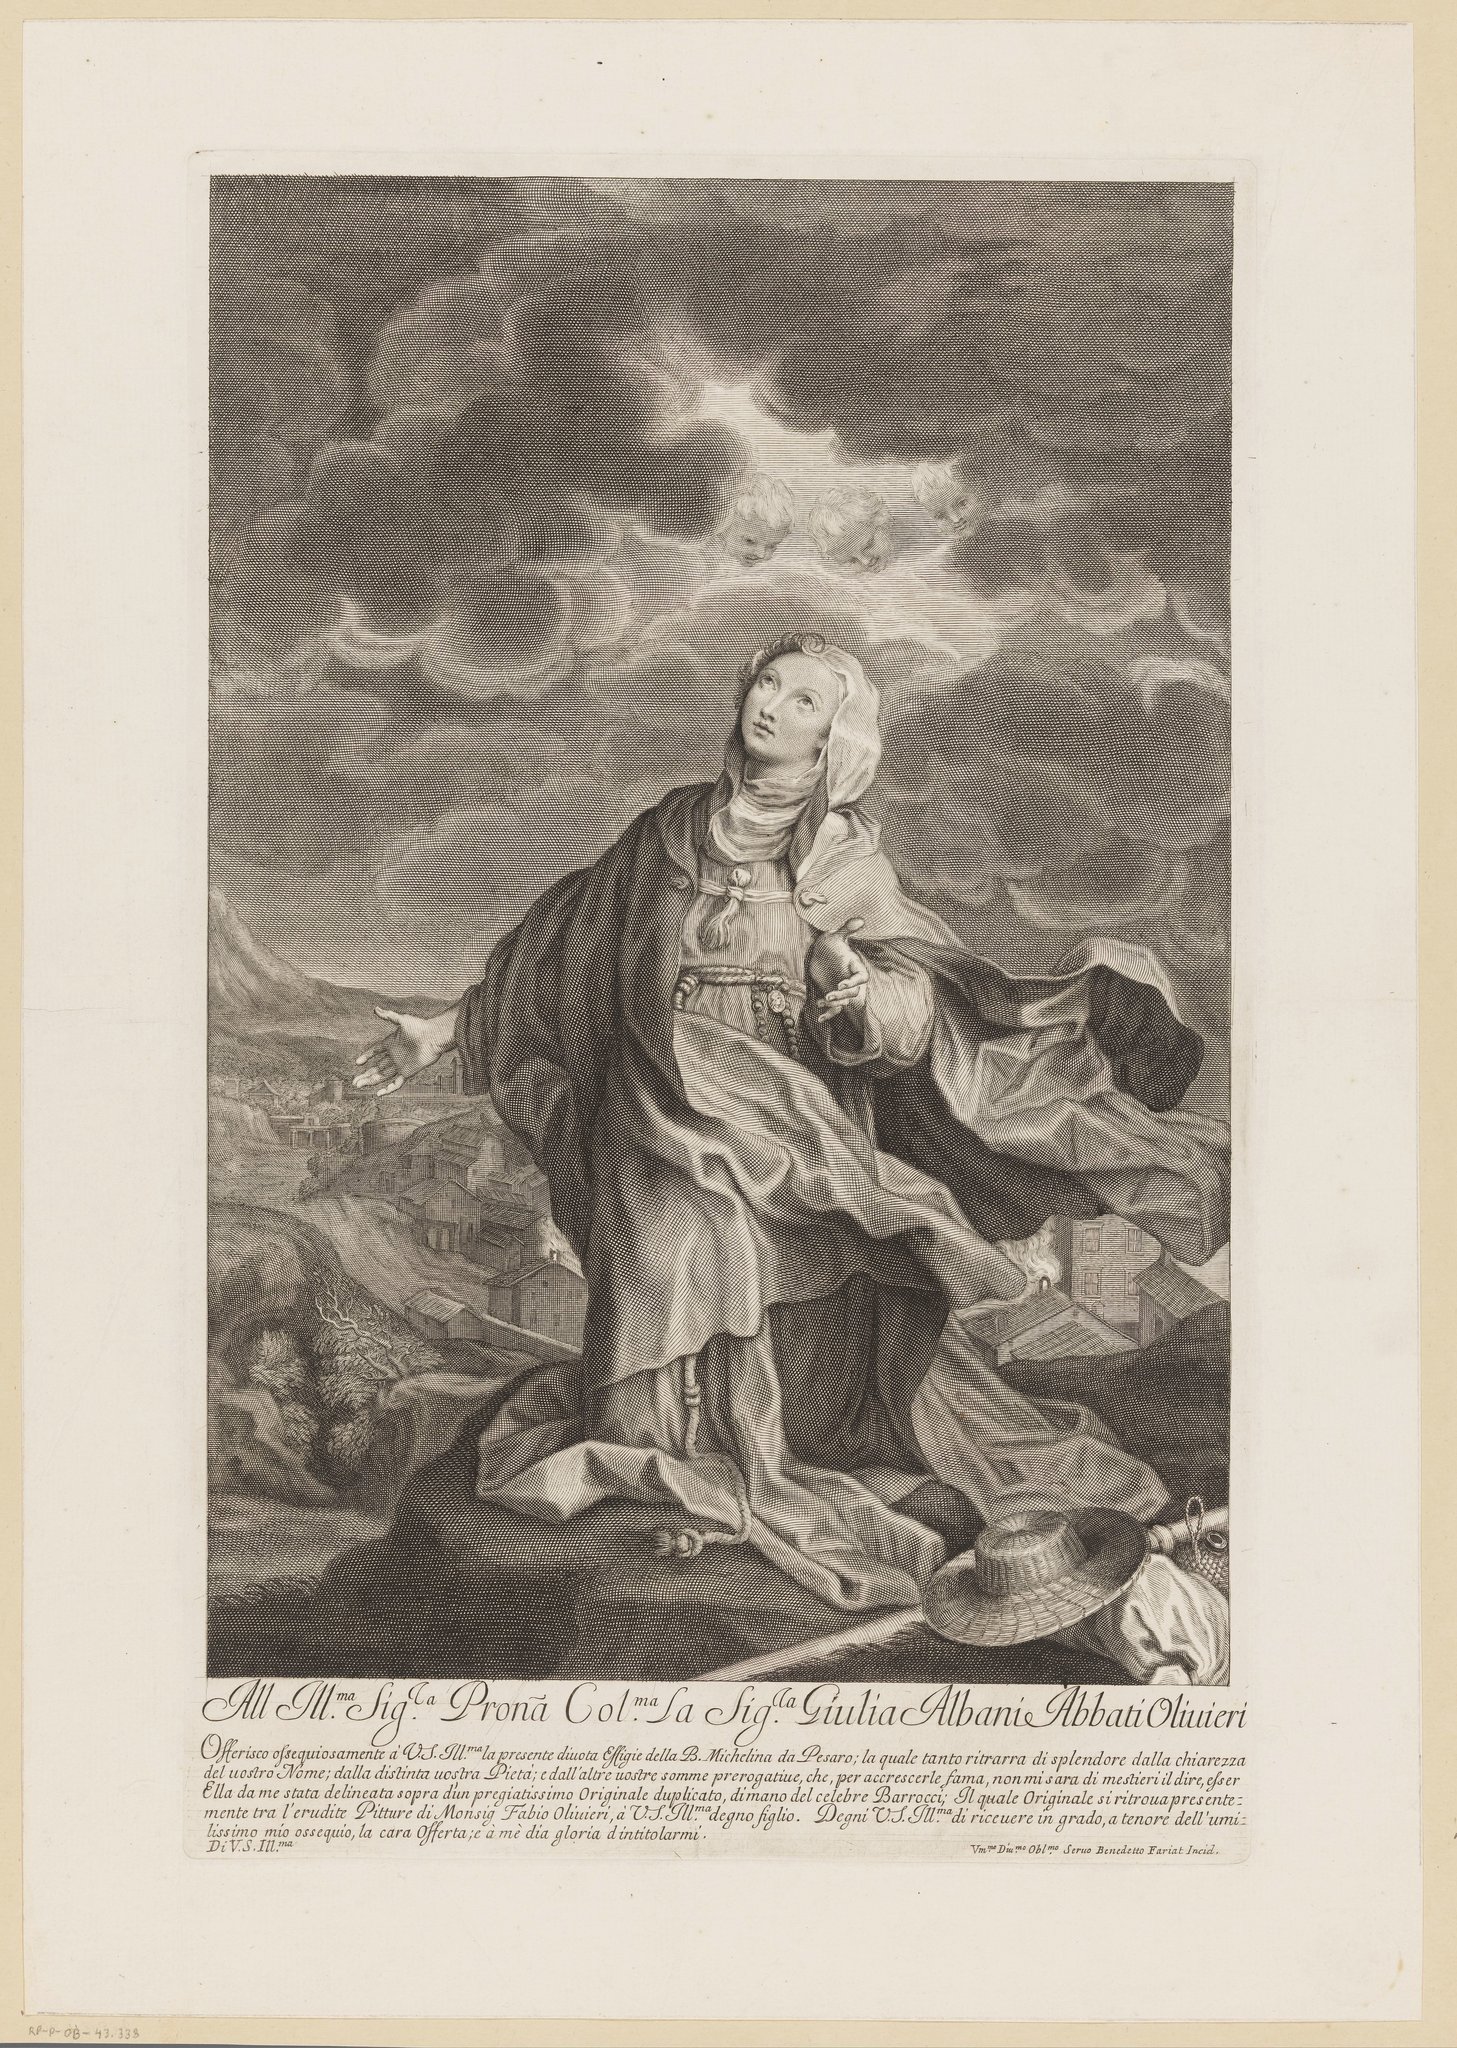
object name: print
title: Michelina da Pesaro opkijkend naar de hemel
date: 1656-1720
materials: paper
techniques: engraving, etching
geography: france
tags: clergyman, city-view, and landscape with man-made constructions, kneeling on both knees - aa - female human figure, activities of angels (in heaven)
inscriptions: collector's mark: Lugt 2228